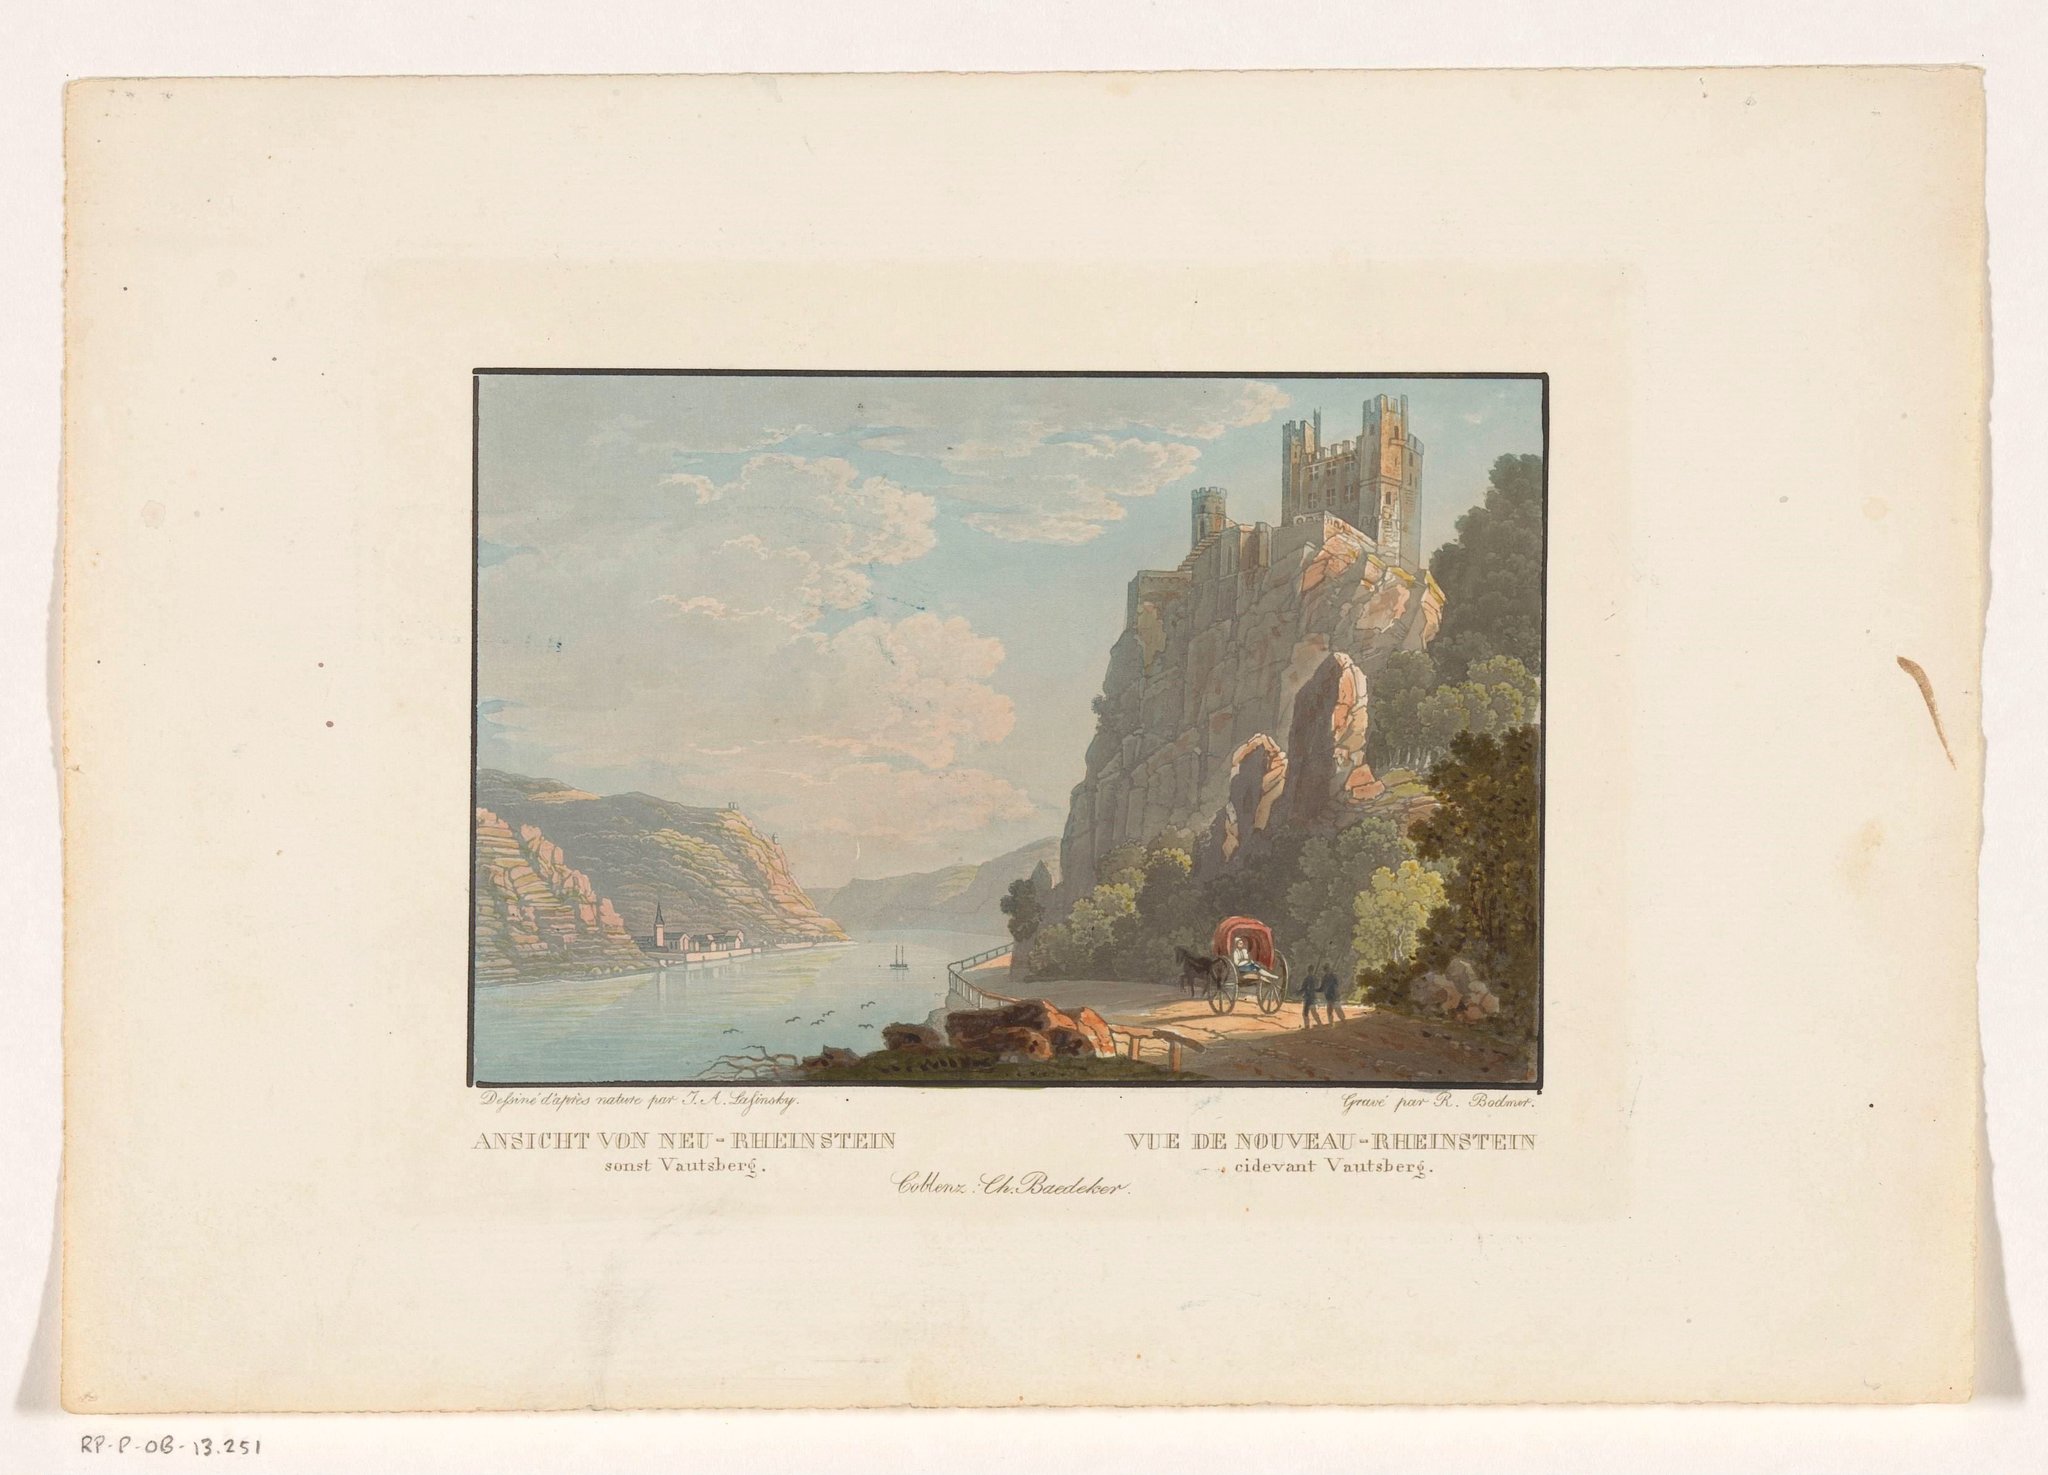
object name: print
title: Ansicht von Neu-Rheinstein sons Vautsberg / Vue de Nouveau-Rheinstein cidevant Vautsberg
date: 1832-1872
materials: paper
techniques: hand coloring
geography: zurich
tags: river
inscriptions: collector's mark: Lugt 2228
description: Vanaf 1828 verschenen bij Franz Friedrich Röhling in Koblenz verschillende uitgaven met prenten van burchten en kastelen gelegen langs de Rijn, vervaardigd door Rudolf Bodmer naar tekeningen van Adolf Lasinsky. Vanaf 1832 verschenen deze publicaties bij Karl Baedeker, die het fonds van Röhling had overgenomen.